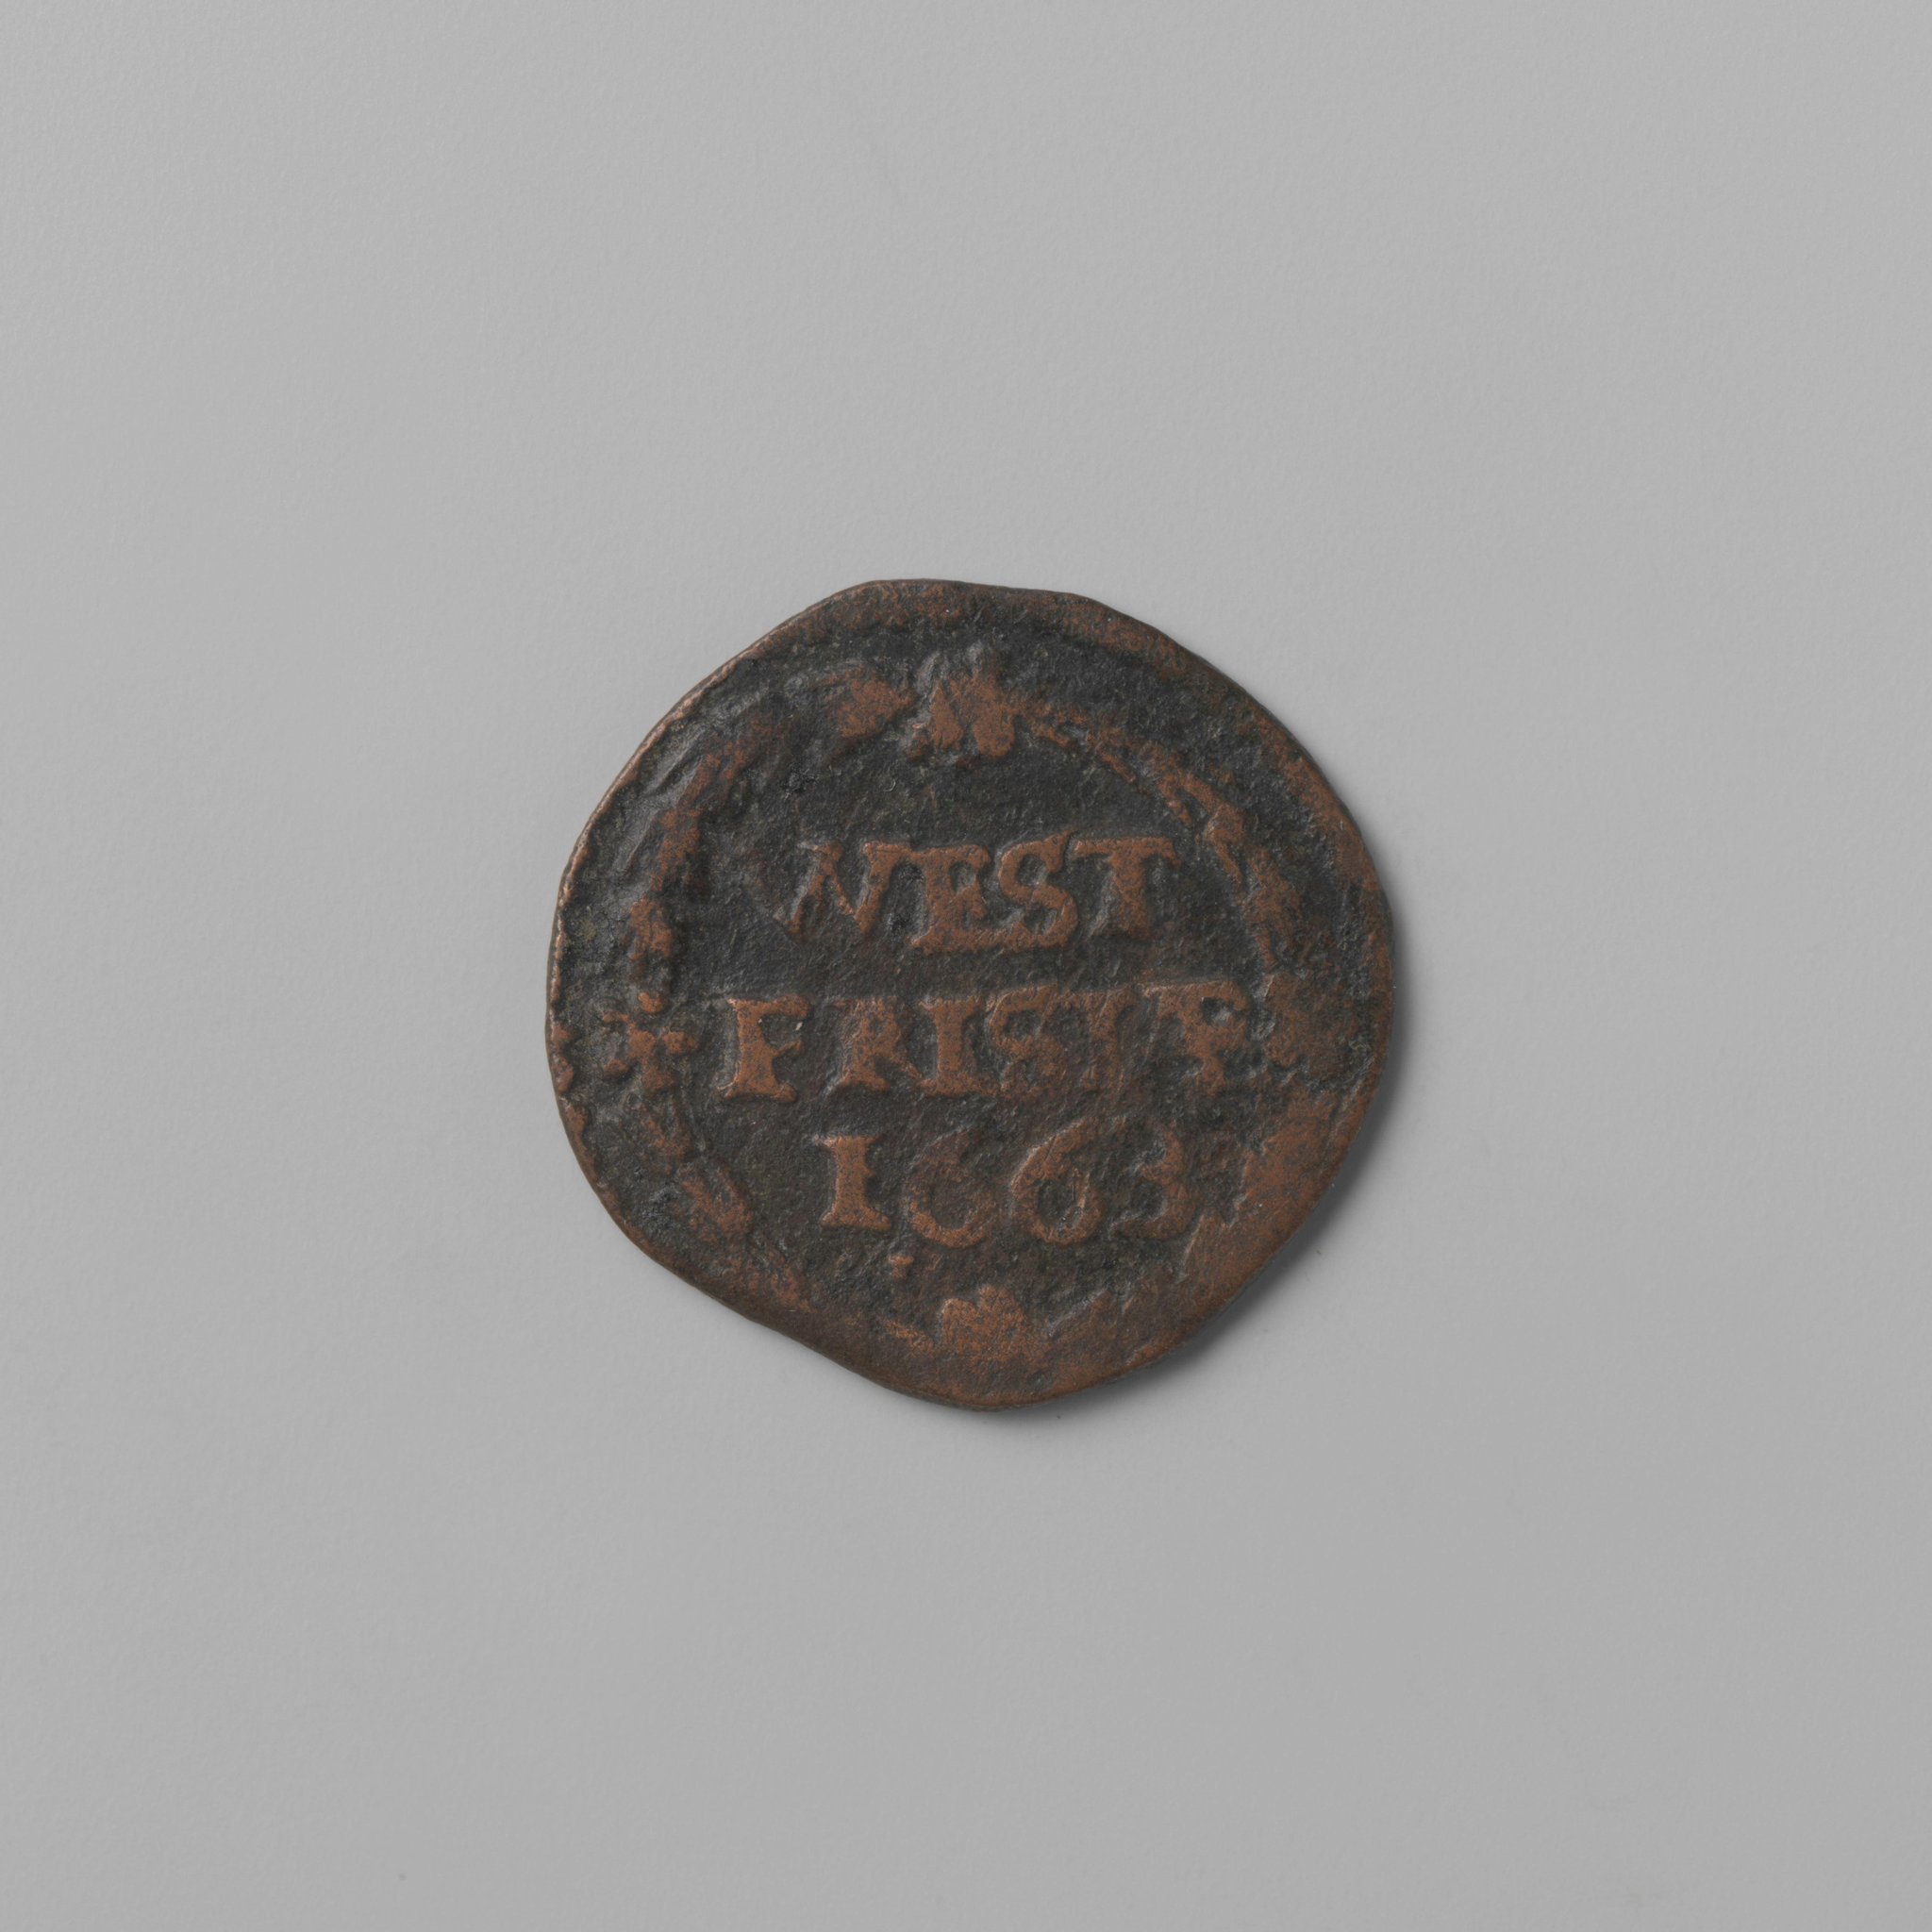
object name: coin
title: Westfriese duit, 1663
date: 1663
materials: copper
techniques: striking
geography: west frisia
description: Koperen munt. Voorzijde: gekroond en versierd wapenschild van West-Friesland. Keerzijde: binnen een bladerkrans opschrift in twee regels, opzij twee rozetten.